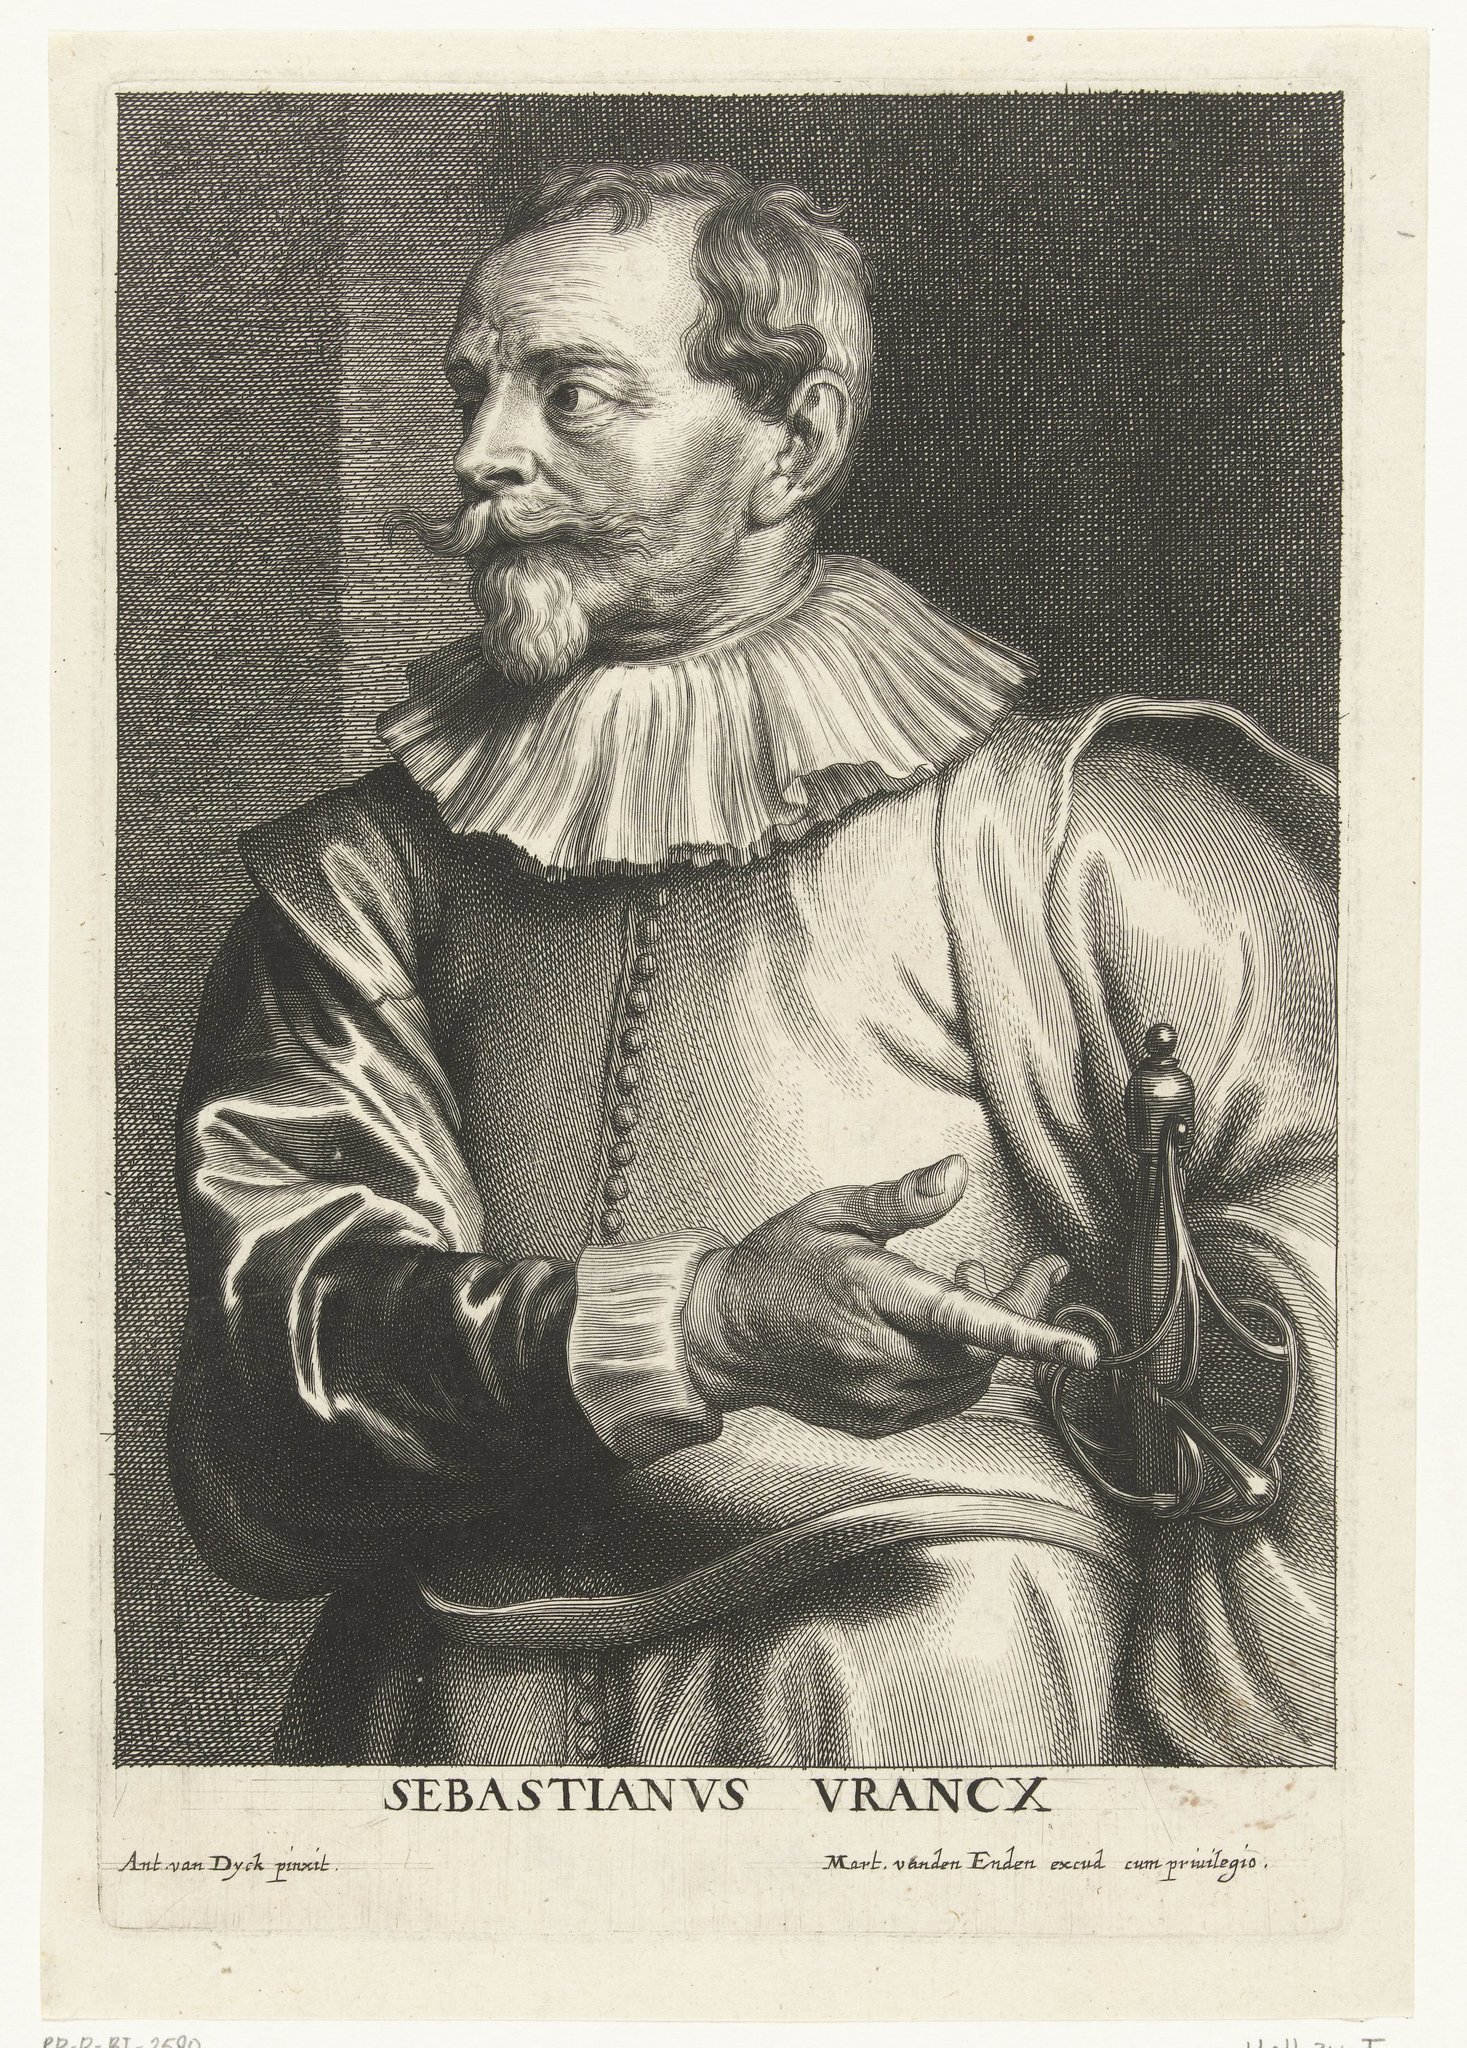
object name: print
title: Portret van schilder Sebastiaan Vrancx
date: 1596-1659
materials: paper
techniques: engraving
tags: painter, draughtsman, sebastiaen vrancx, portrait, self-portrait of painter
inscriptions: collector's mark: Lugt 240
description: Prent naar schilderij van Anthony van Dyck.